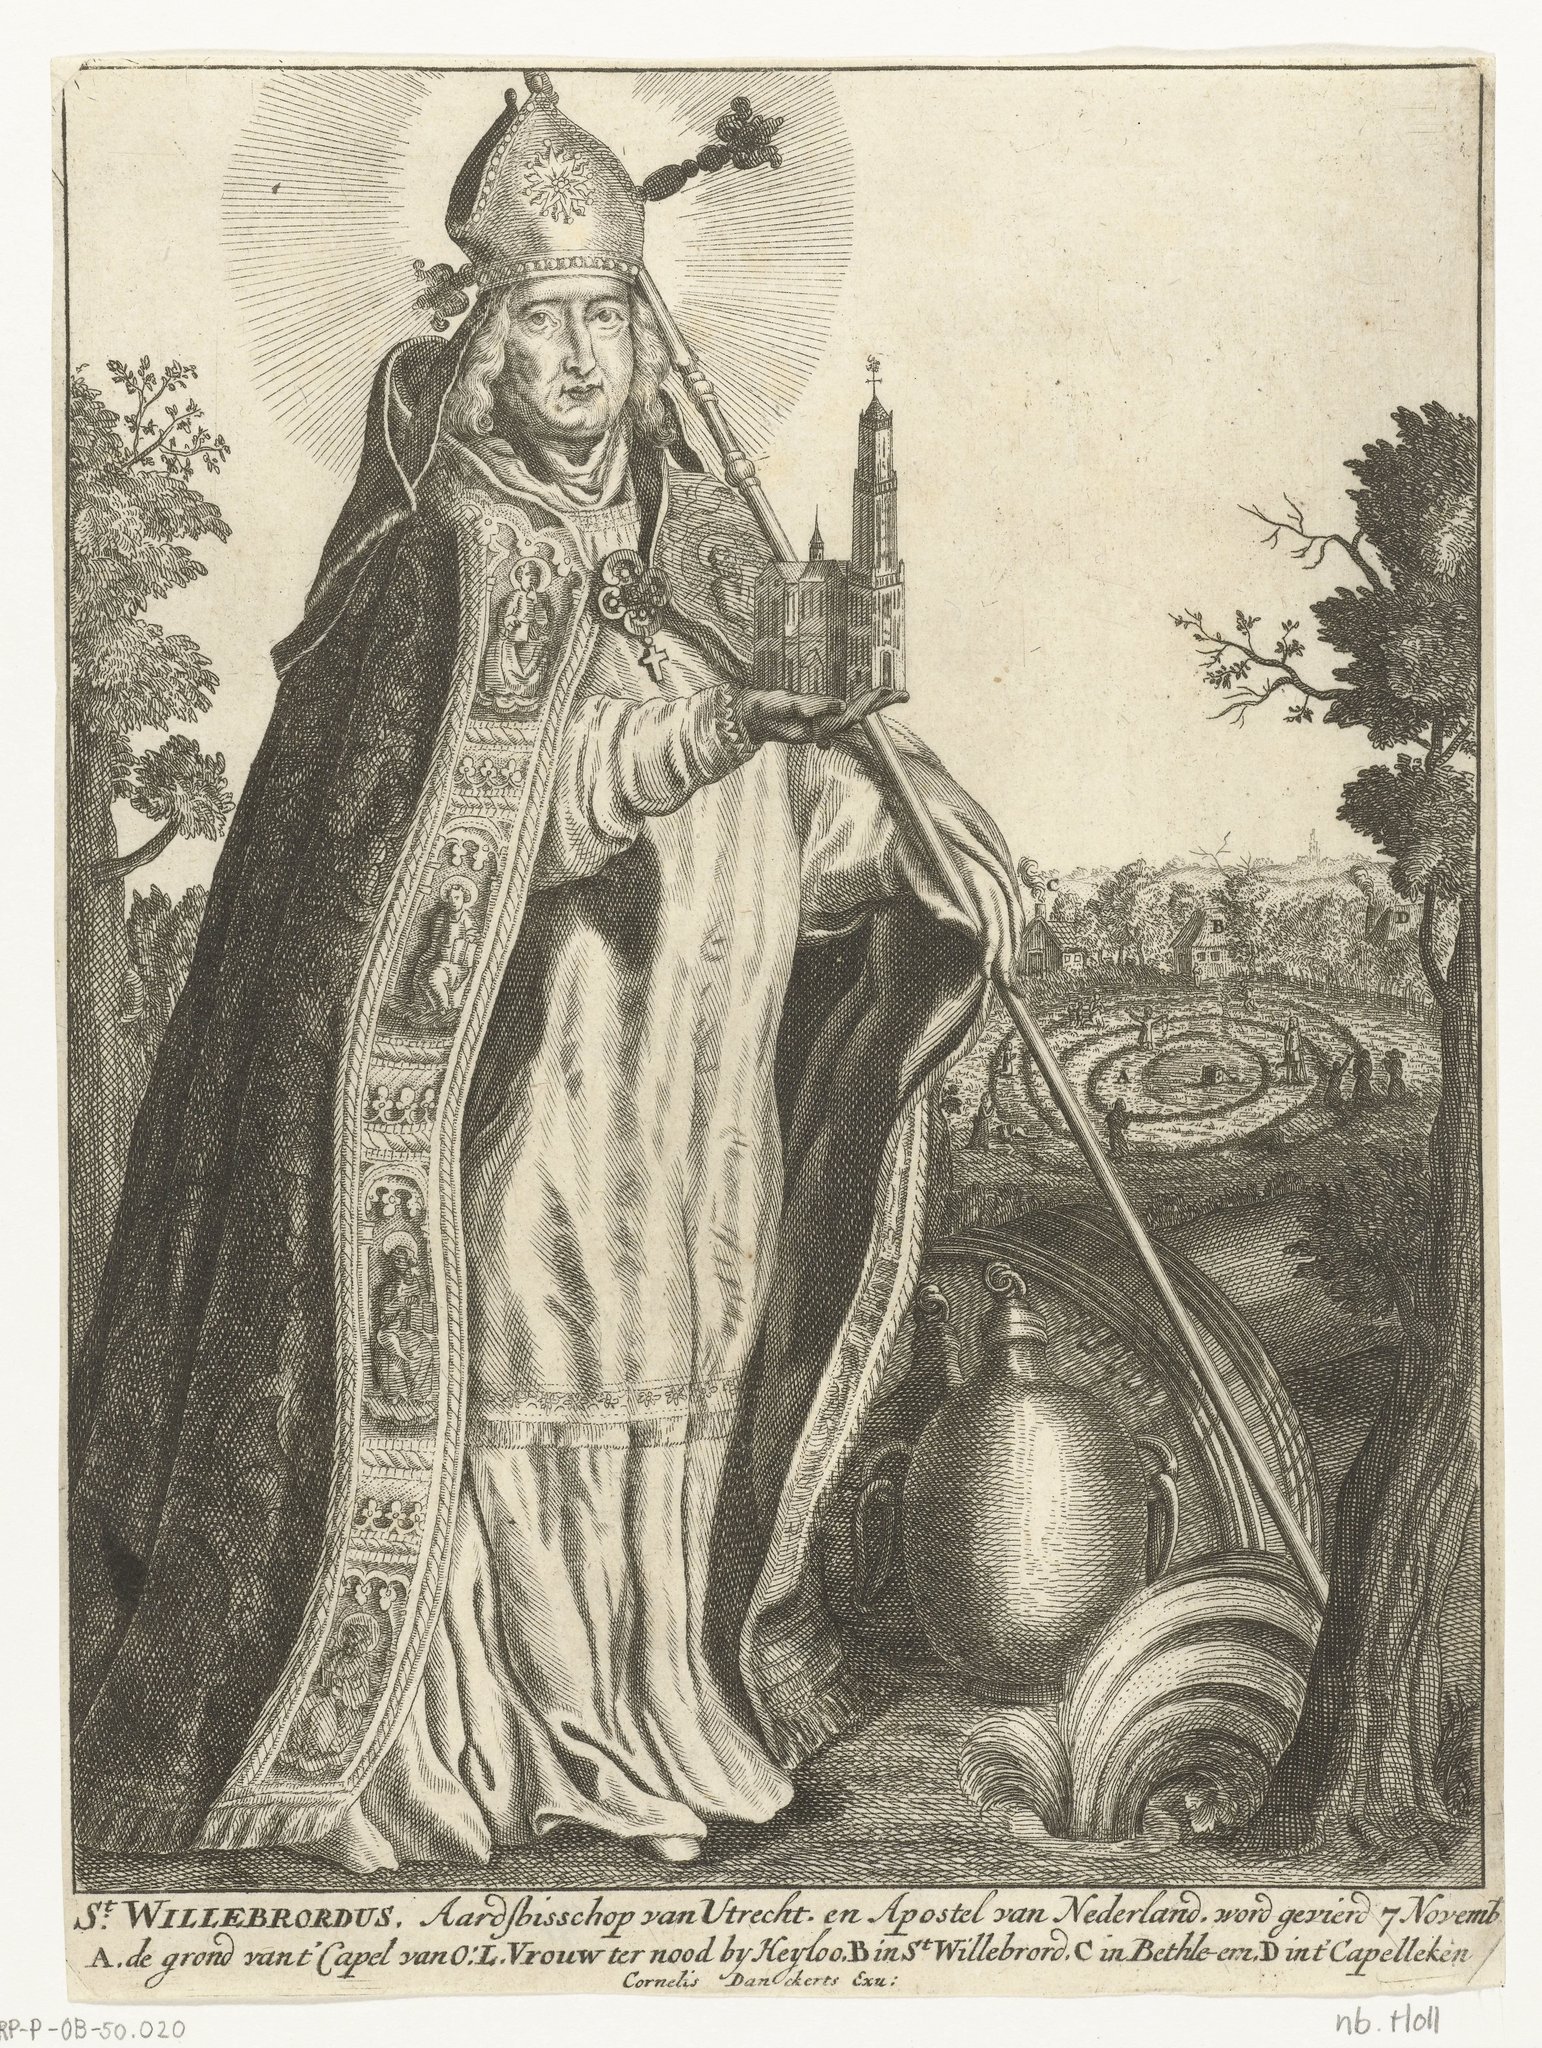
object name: print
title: Heilige Willibrordus als aartsbisschop met kerkmodel van Dom te Utrecht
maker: cornelis danckerts (i)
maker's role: print maker, publisher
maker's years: 1604-1656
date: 1613-1656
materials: paper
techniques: engraving, etching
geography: netherlands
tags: the 'apostle of frisia' and archbishop of utrecht, willibrord (of echternach); possible attributes: cask (barrel), well (fountain), child (on a book), model of church, stone bottles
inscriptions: collector's mark: Lugt 2228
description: Heilige Willibrordus als aartsbisschop van Utrecht, staand gekleed in kazuifel en bisschopsmijter op zijn hoofd. Bij zijn voeten ontspringt een bron en wijnvaten staan naast hem. In zijn hand houdt hij een kerkmodel van de Dom te Utrecht. In de ondermarge worden een bedevaart en locaties genoemd waar op 7 november de heilige wordt herdacht. Deze zijn in het landschap aangeduid: pelgrims bezoeken de plaats waar de kapel voor Onze Lieve Vrouwe ter Nood te Heiloo stond en ook Willibrordus werd vereerd en de plaatsen Sint Willebrord en Bethlehem.